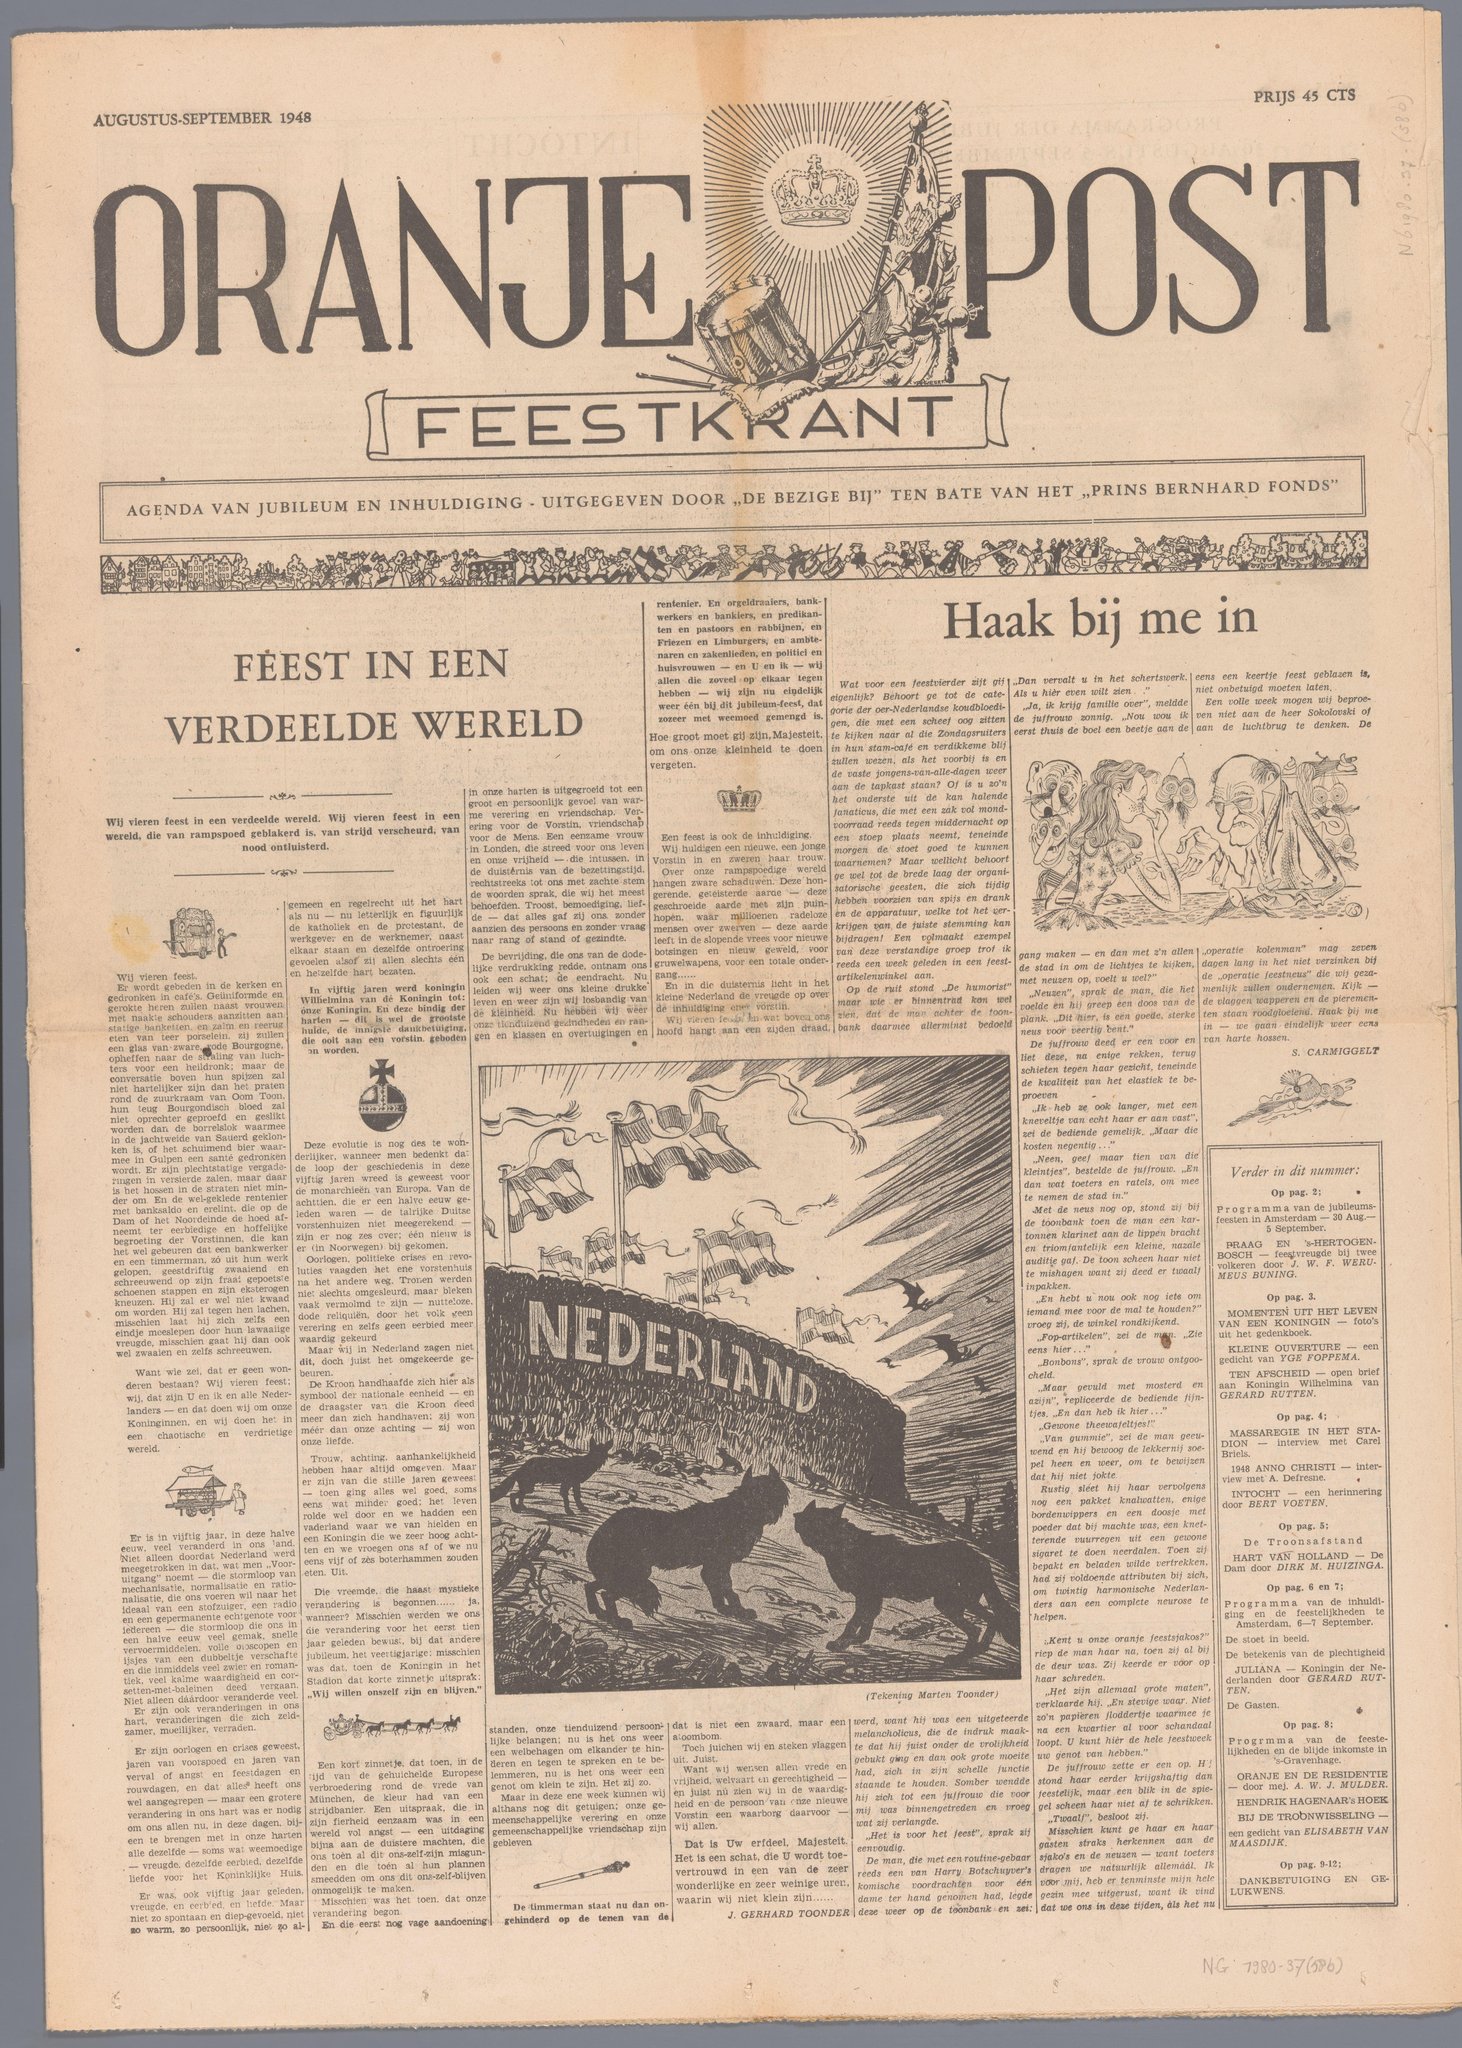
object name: newspaper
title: Oranjepost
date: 1909-1948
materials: paper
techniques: printing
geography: amsterdam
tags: wilhelmina of the netherlands, the hague, juliana of the netherlands, netherlands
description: Krant over de inhuldiging van Juliana, speciale krant, 12 genummerde pp.